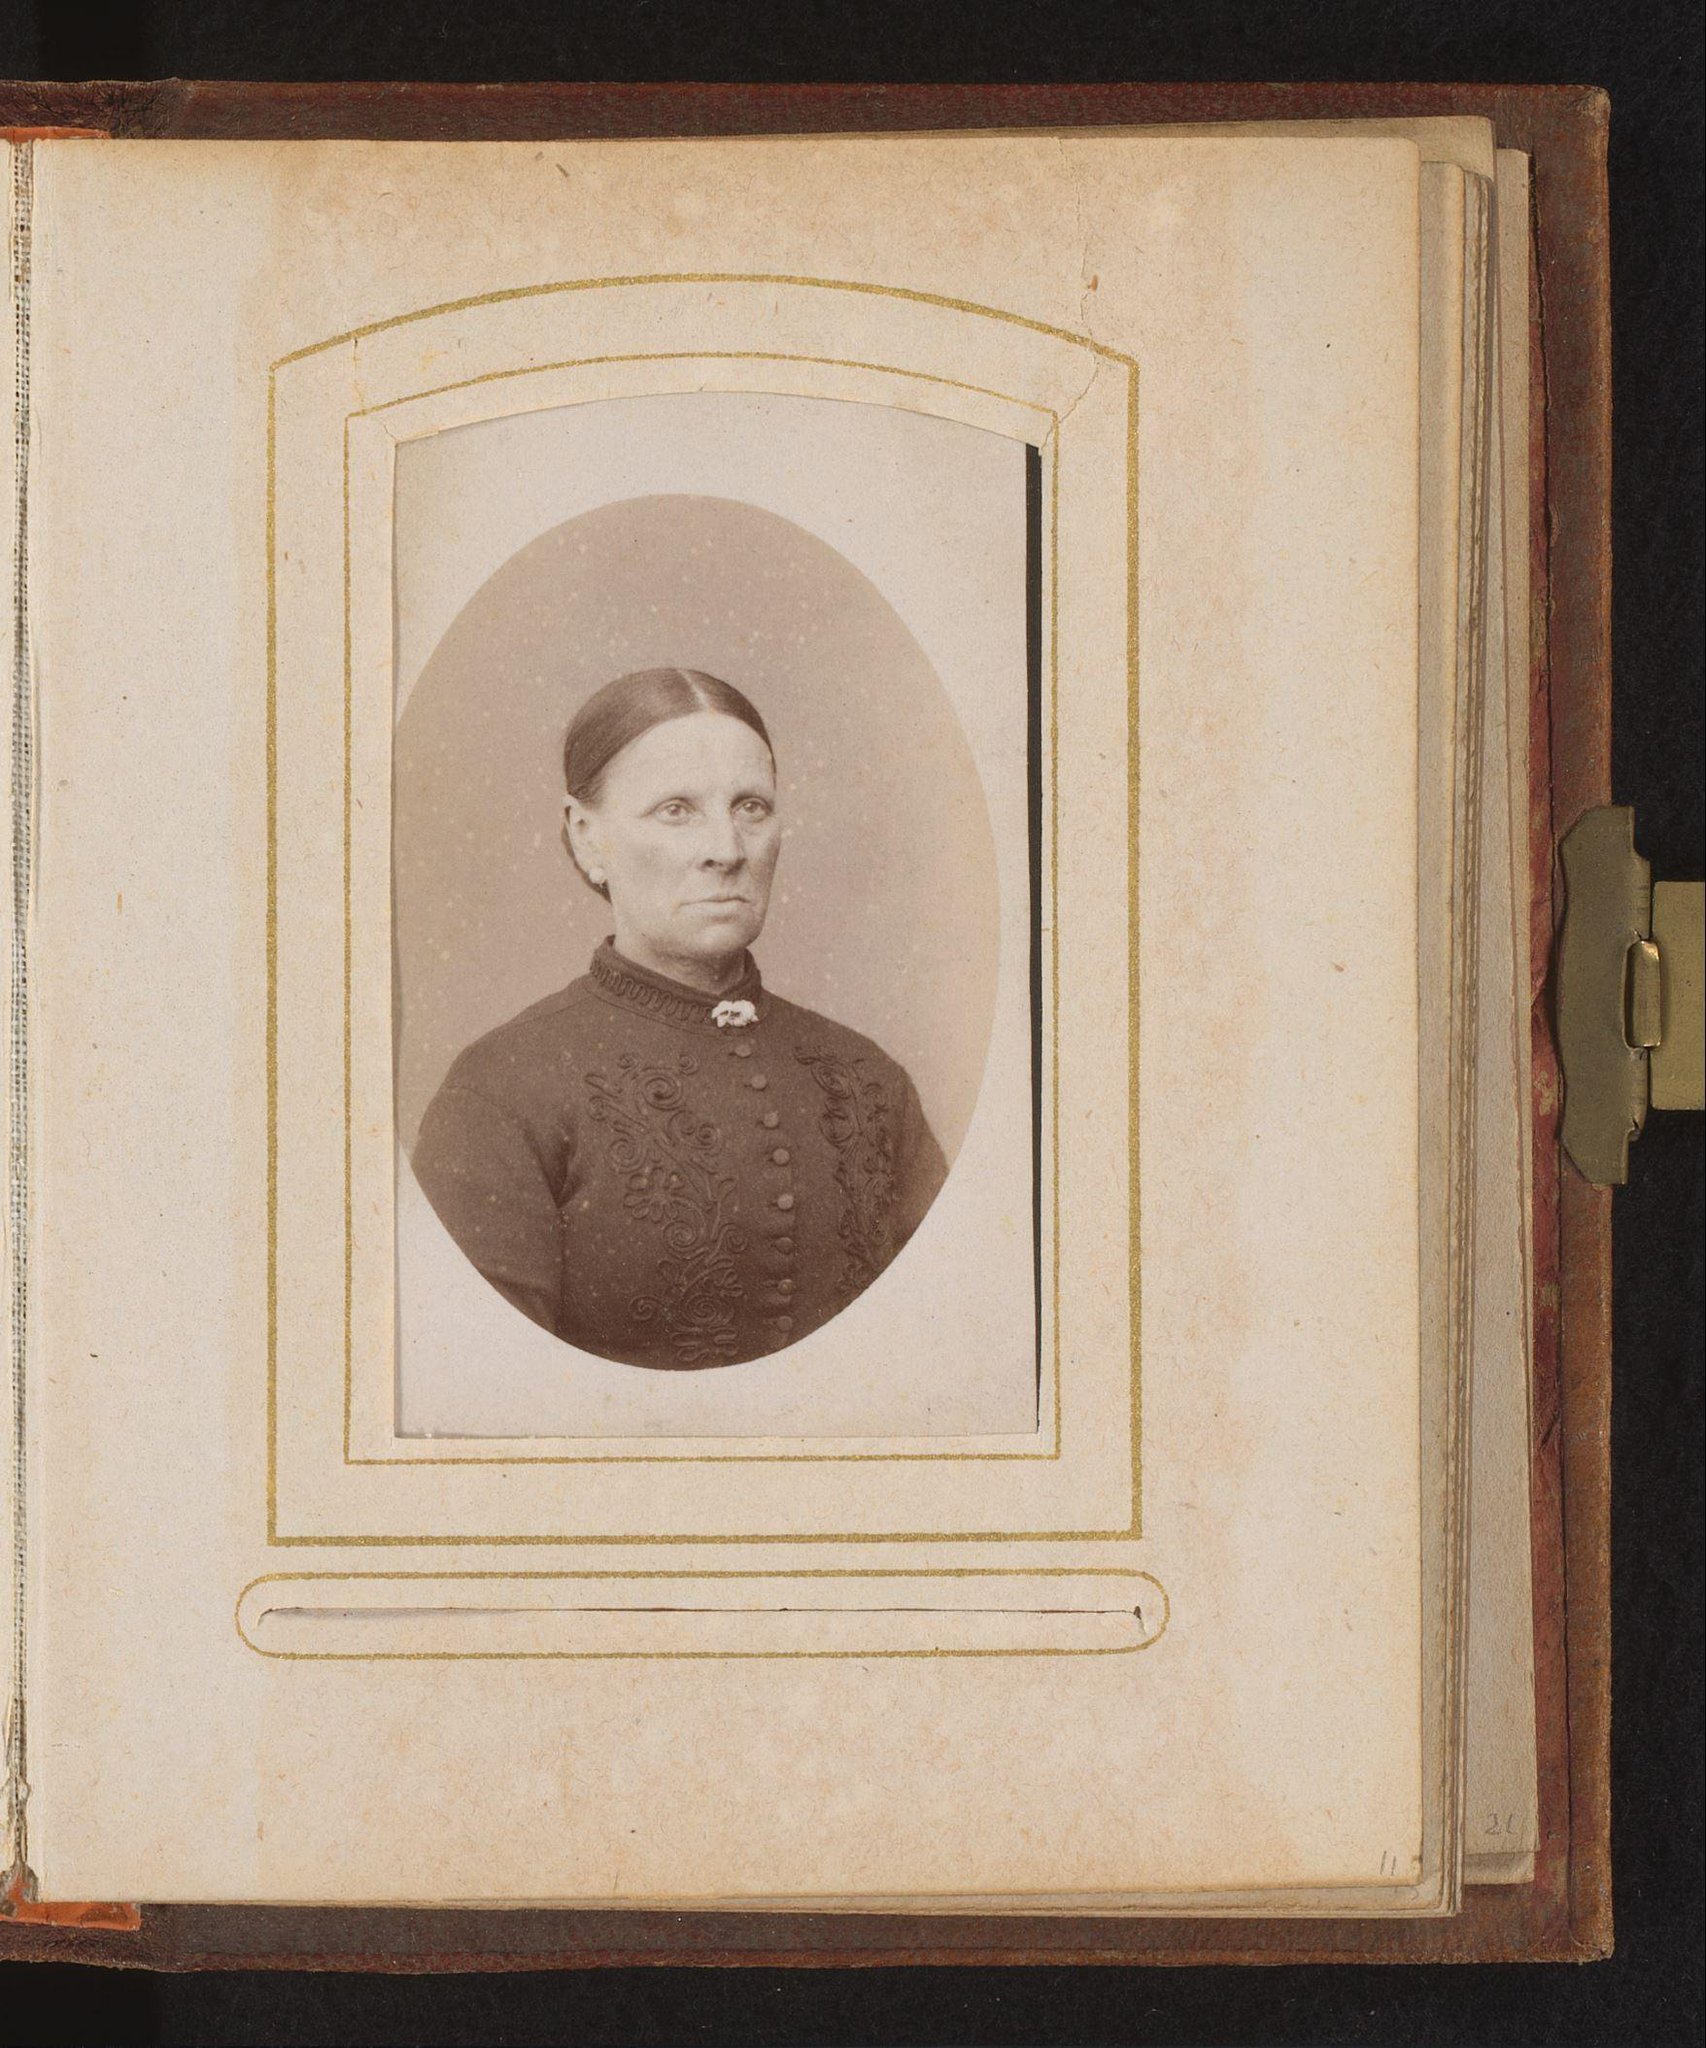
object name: photograph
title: Portret van een vrouw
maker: Anonymous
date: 1850-1890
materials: cardboard, photographic support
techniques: albumen print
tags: adult woman, historical persons